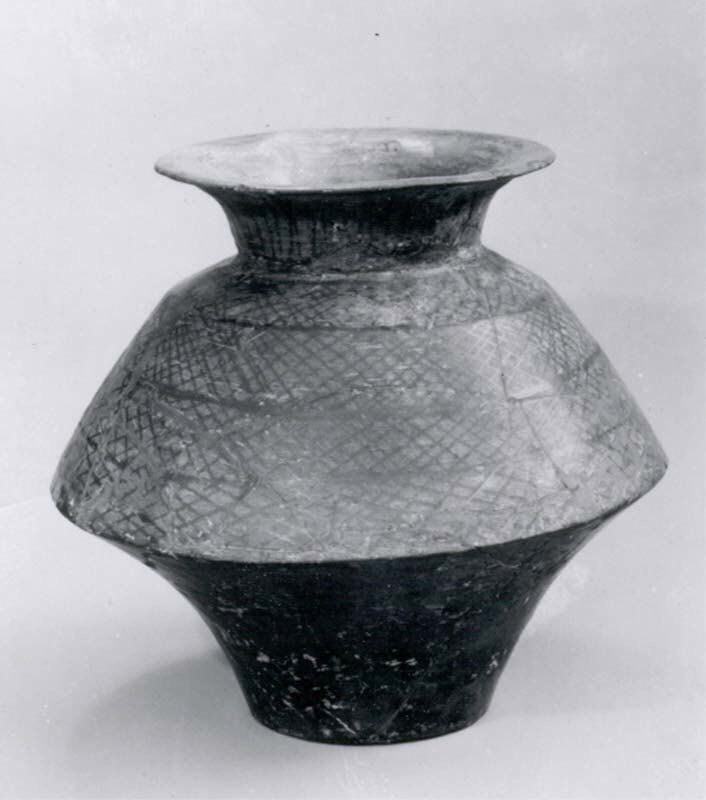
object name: jar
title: Carinated jar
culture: iranian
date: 3000-2250 BCE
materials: ceramic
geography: iran